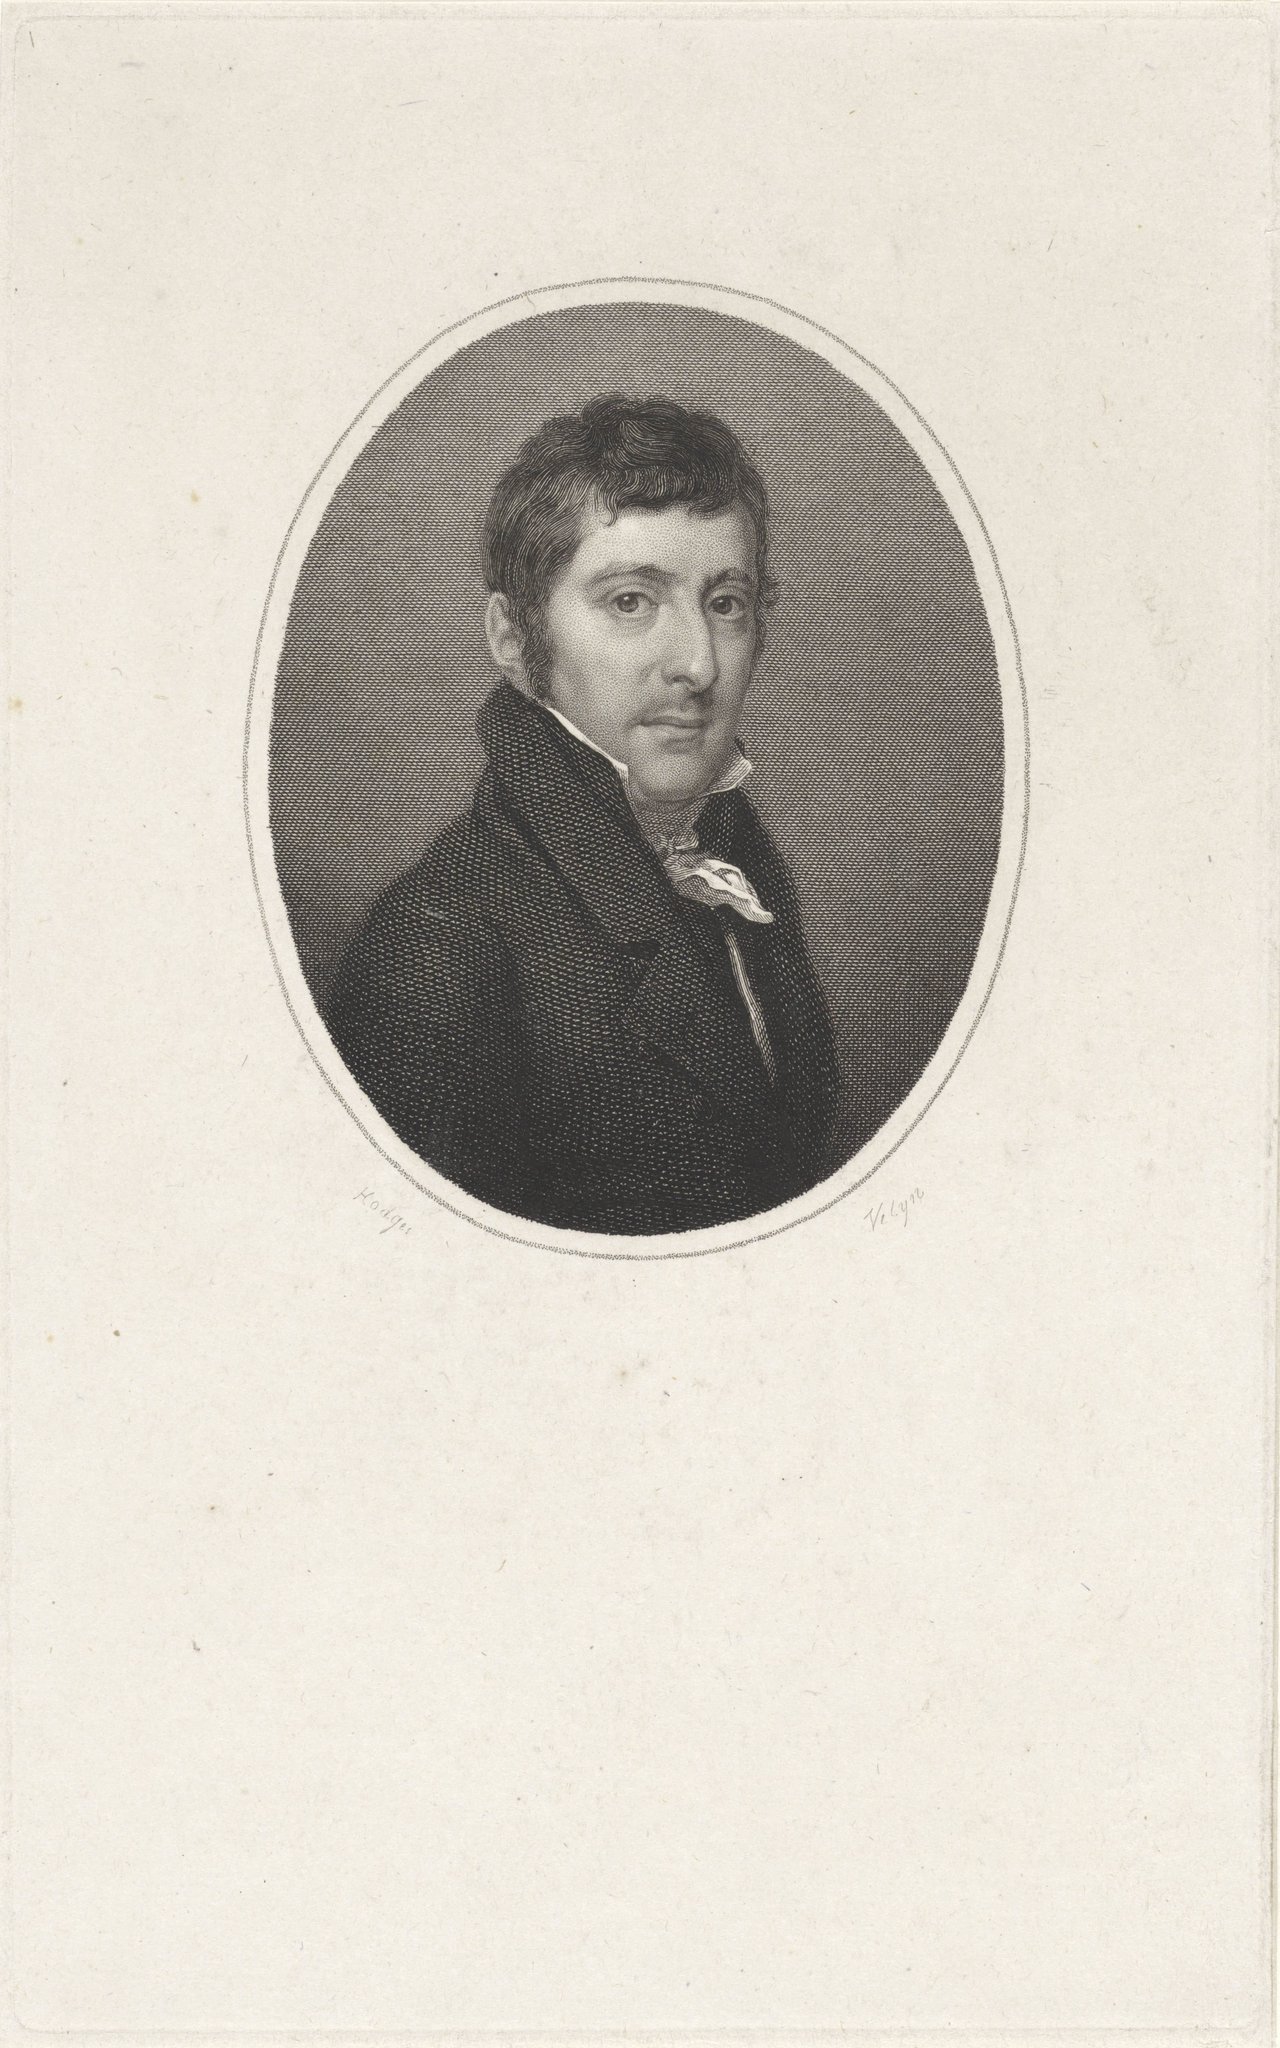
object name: print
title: Portret van Robert Hendrik Arntzenius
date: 1797-1836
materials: paper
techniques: engraving, etching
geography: netherlands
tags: haarlem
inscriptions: collector's mark: Lugt 2228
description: Portret van Robert Hendrik Arntzenius, classicus, dichter en jurist te Amsterdam.